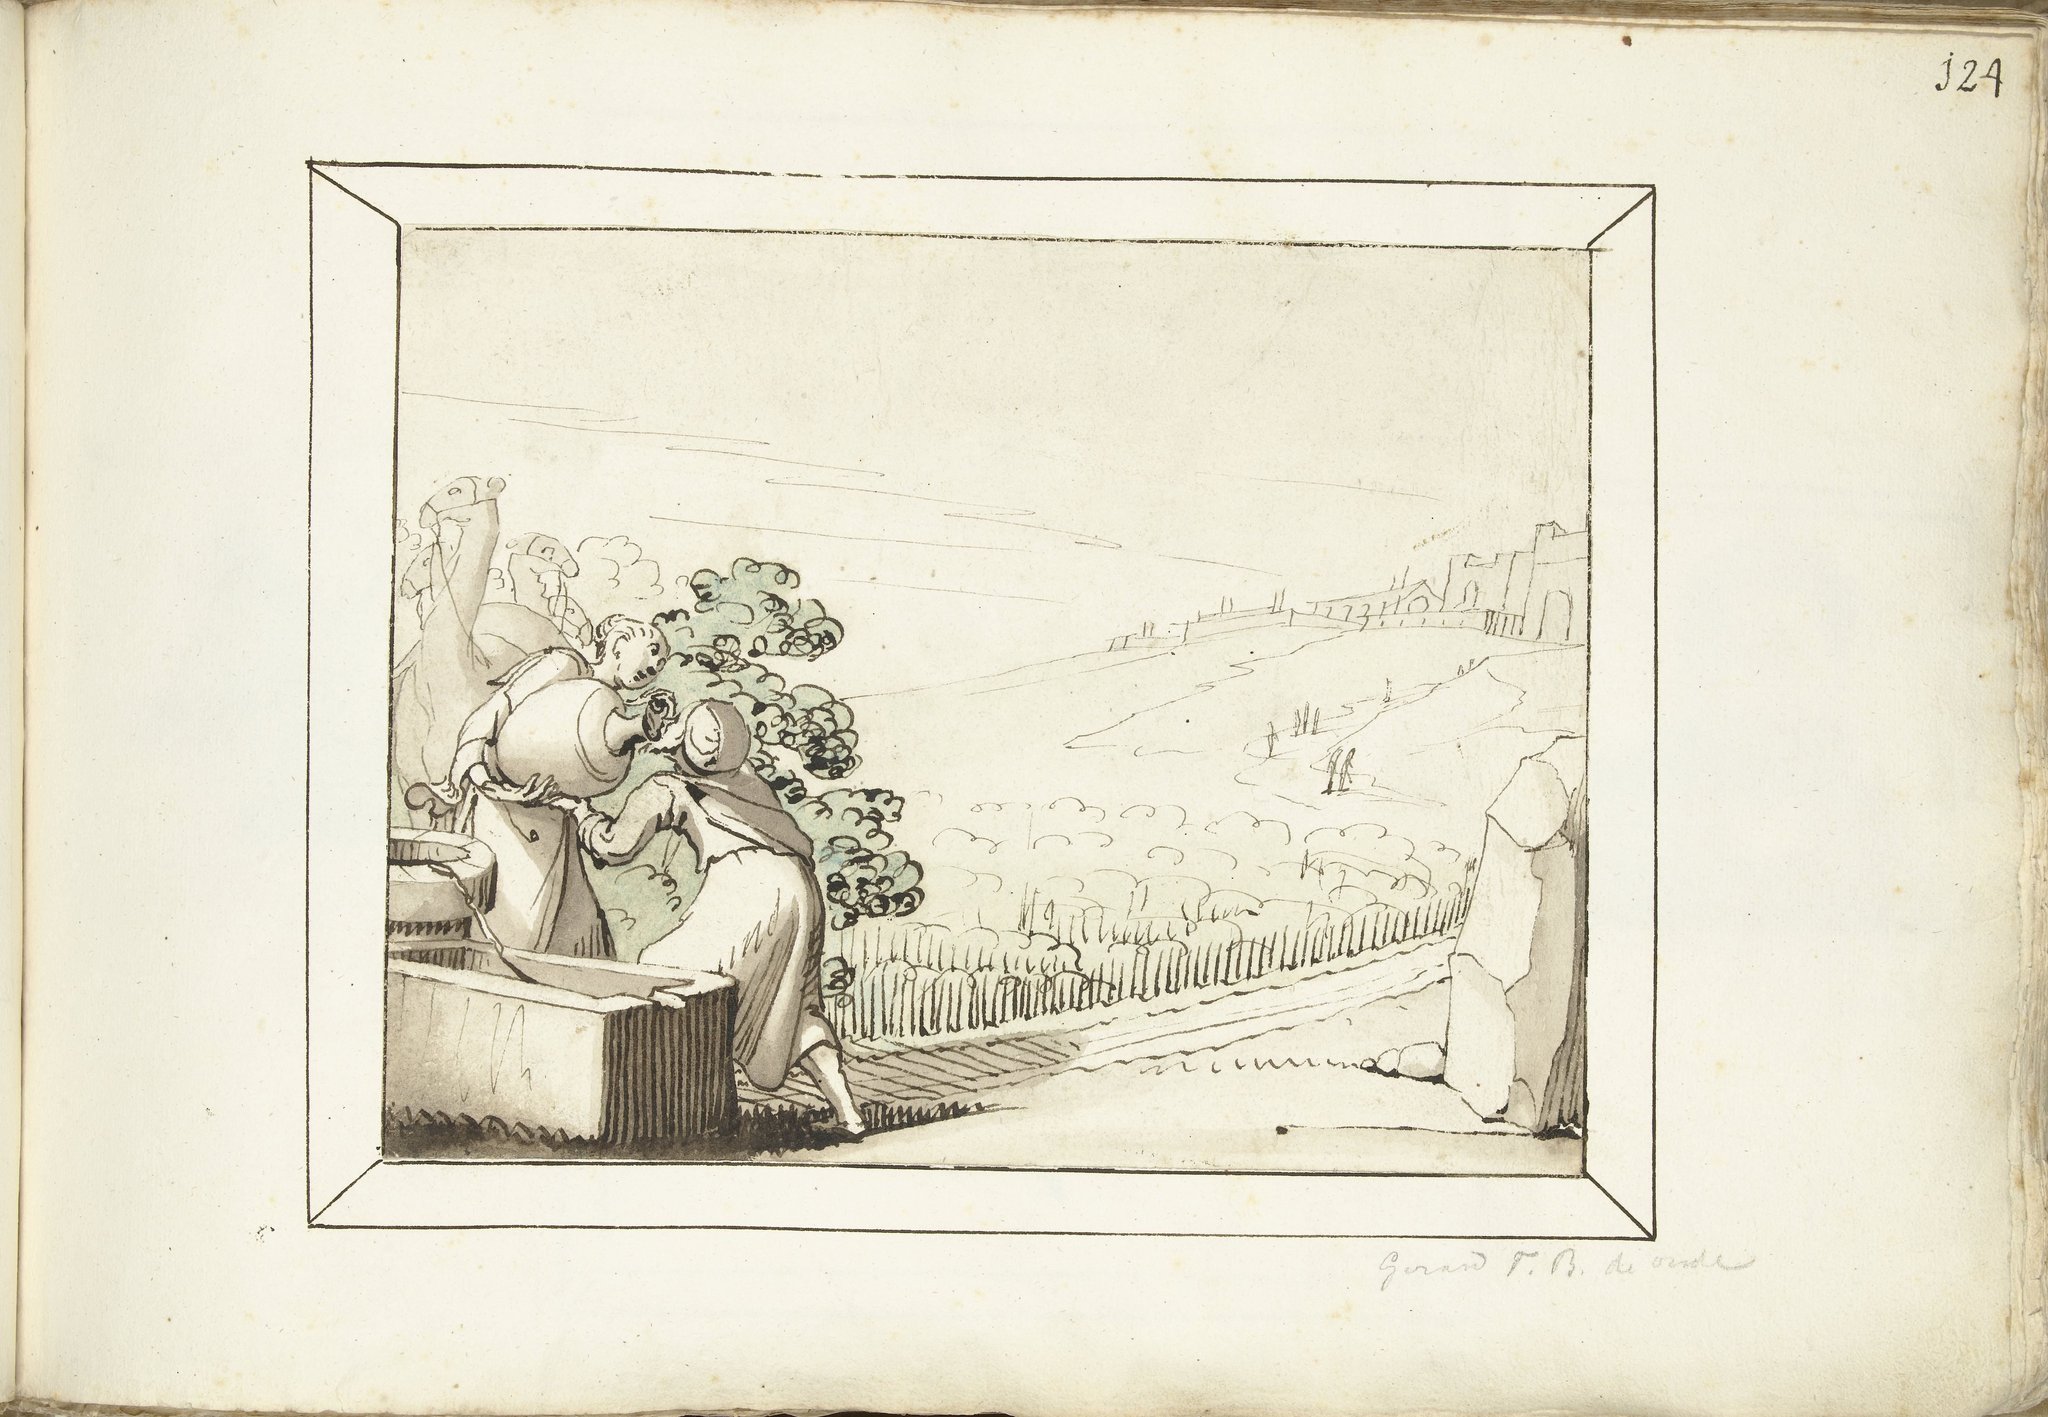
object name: watercolor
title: Rebecca en Eliëzer bij de bron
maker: gerard ter borch (i)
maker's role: draughtsman, print maker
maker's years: 1584-1662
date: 1610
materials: ink, paper, watercolor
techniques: brush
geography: italy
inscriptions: annotation: ‘Gerard T. B. de oude’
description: De tekening is opgeplakt in het Familie-plakboek.